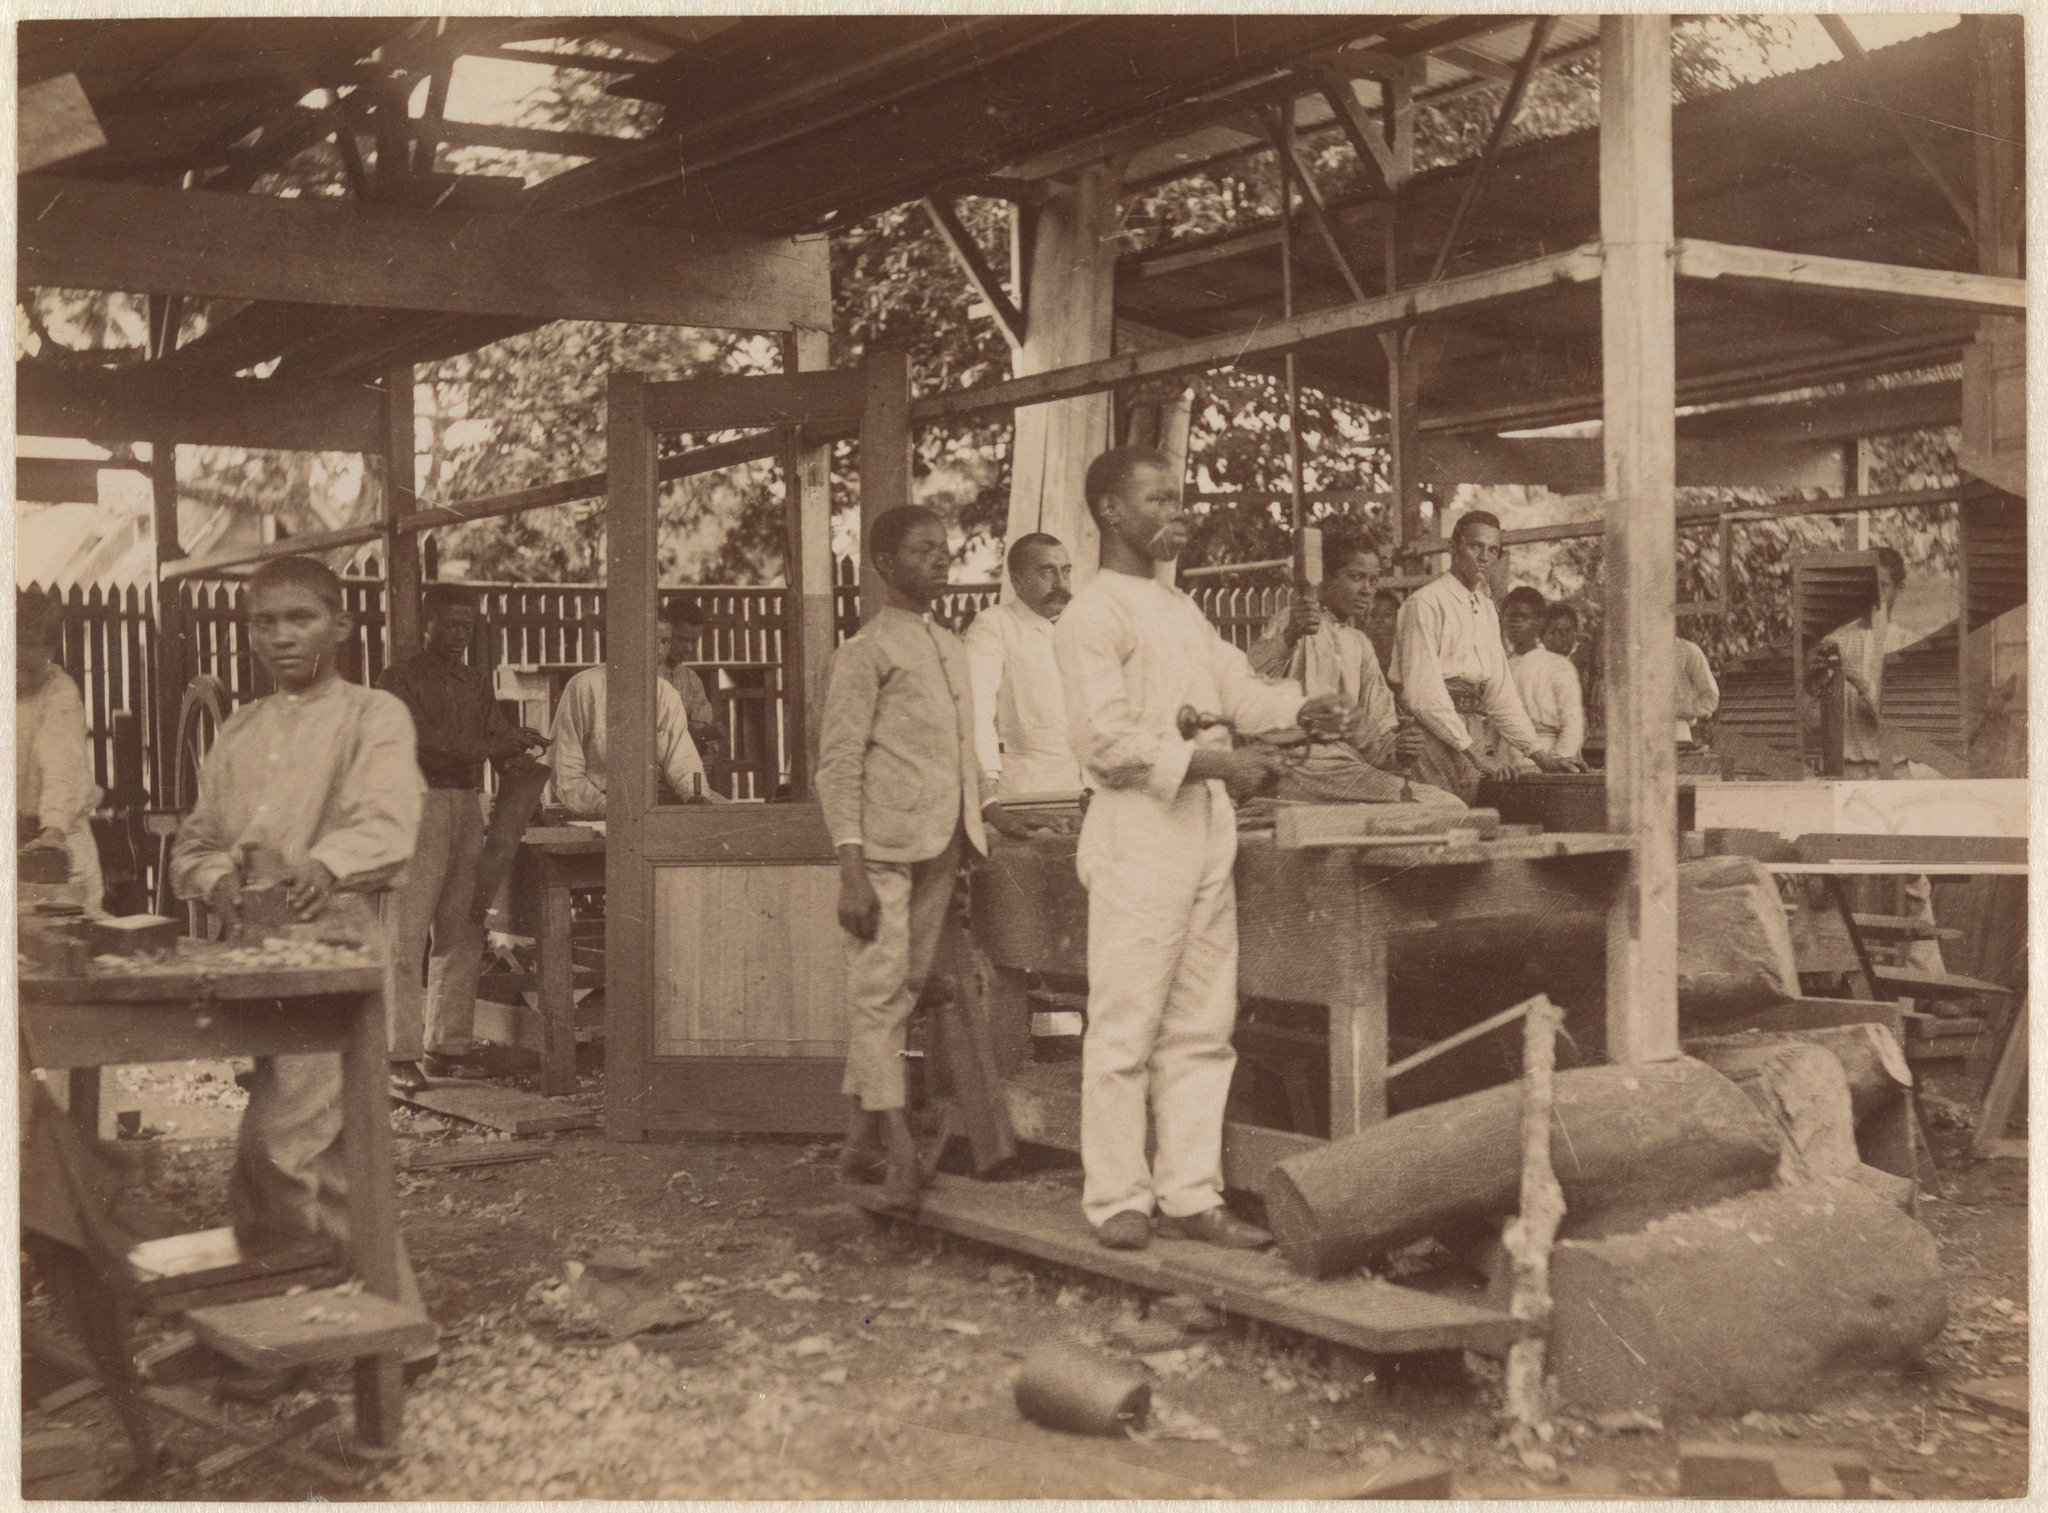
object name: photograph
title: Ambachtschool Werk & Constructiewinkel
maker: julius muller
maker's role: official, politician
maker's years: 1846-1902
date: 1893-1902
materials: photographic support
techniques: albumen print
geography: suriname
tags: avondschool voor handwerkslieden, paramaribo (stad)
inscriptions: inscription: ‘Ambachtschool Werk & Constructiewinkel’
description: Zicht op de houtwerkplaats met leerlingen van de in 1893 opgerichte Ambachtschool Werk en Constructiewinkel in Paramaribo. De werkplaats hoorde bij de Avondschool voor Handwerkslieden die in 1888 was opgericht.